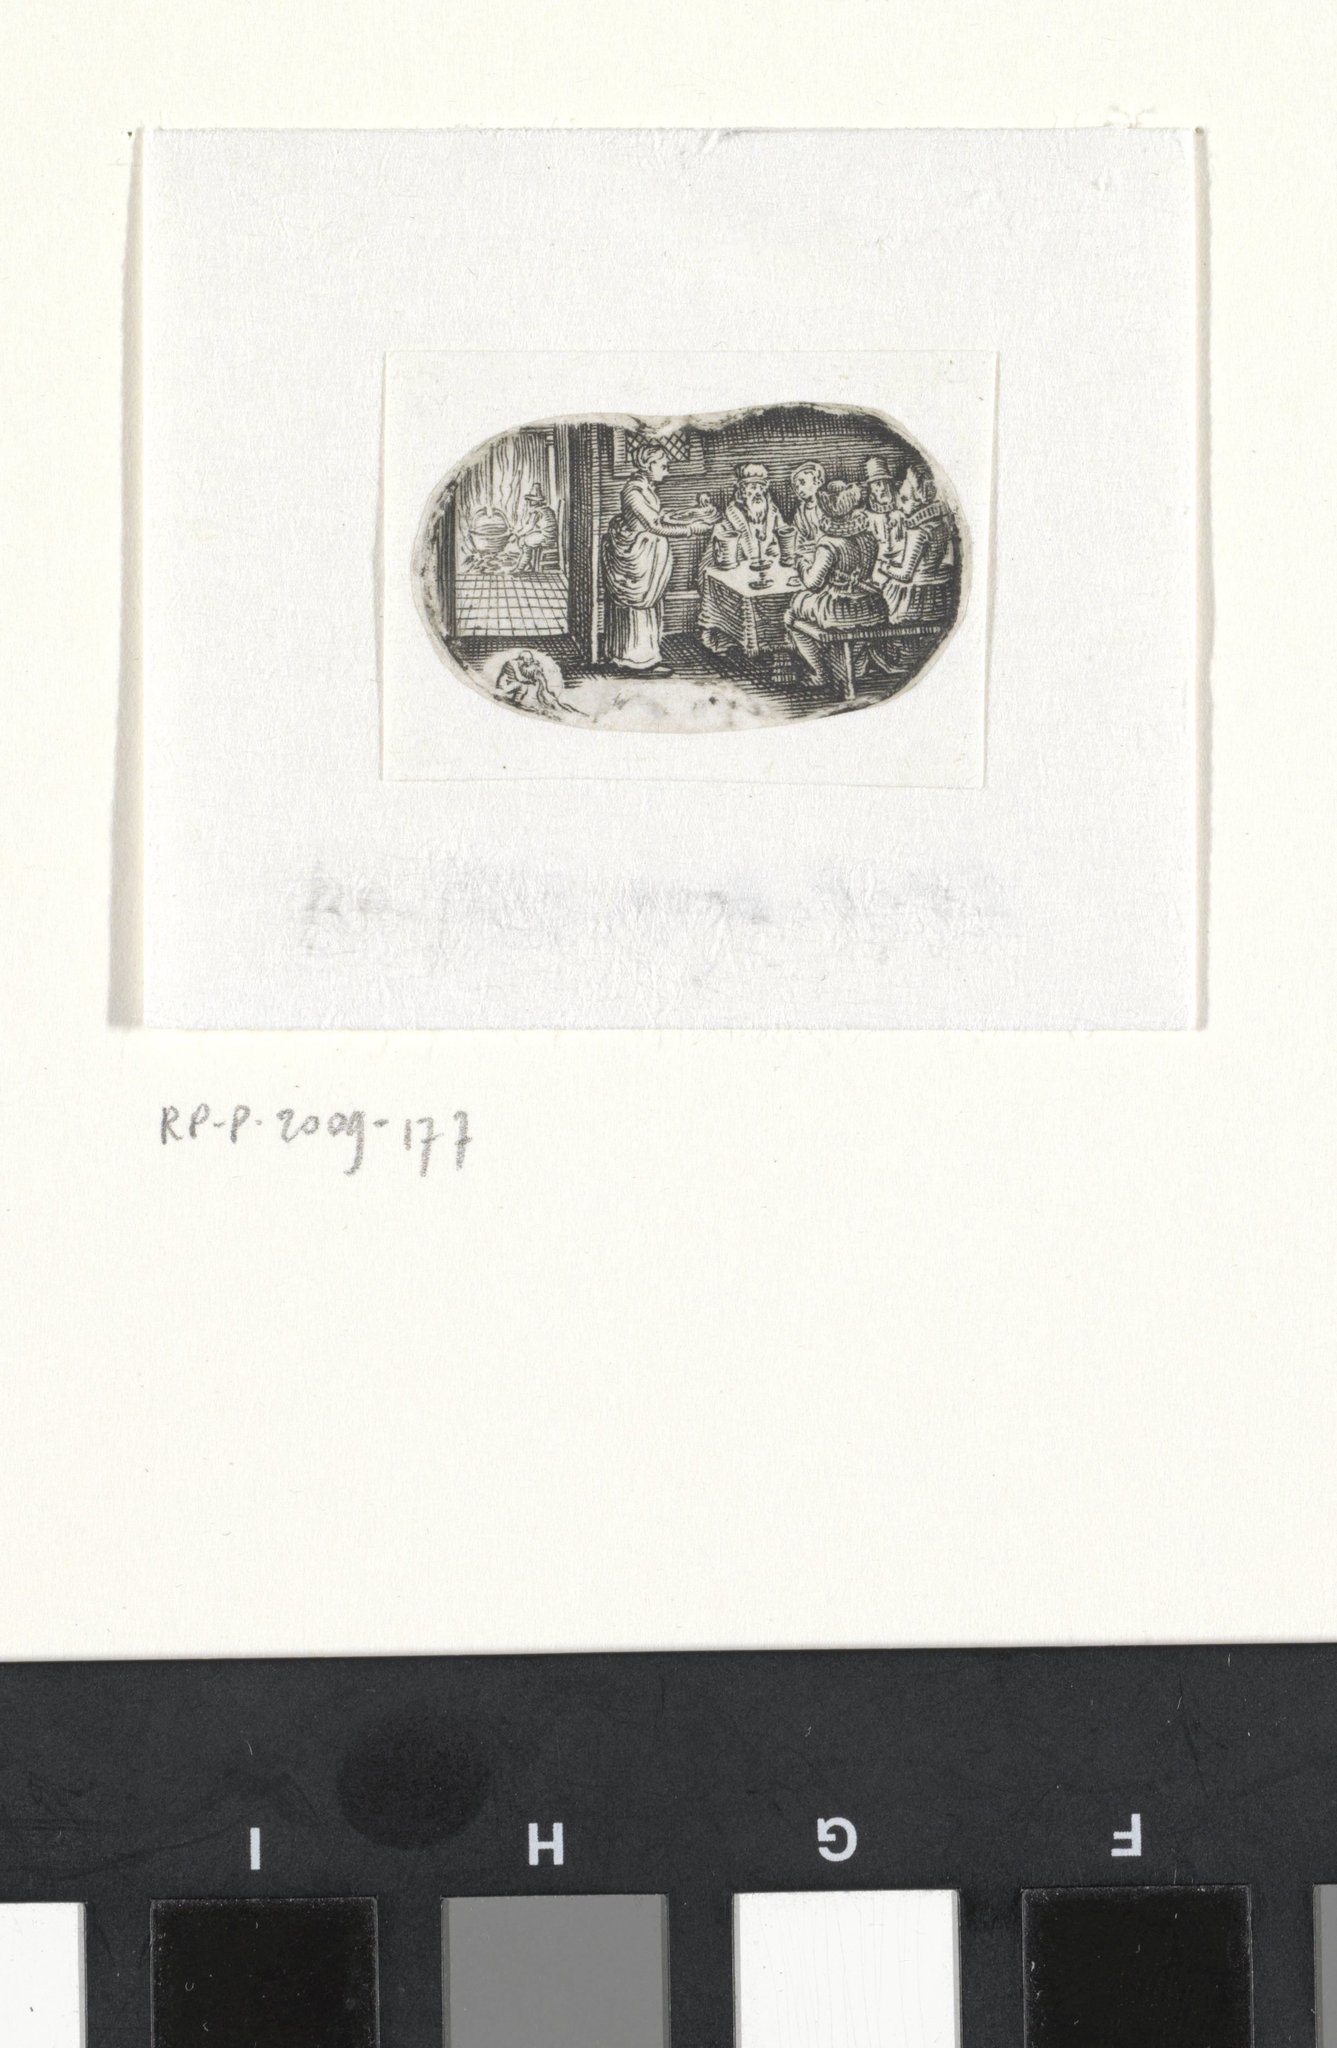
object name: print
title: Januari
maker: Anonymous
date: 1625-1700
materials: paper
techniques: engraving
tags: january and its 'labours', warming oneself at a fire (or hearth, stove, fire-pan, brazier), evening meal, dinner, supper, aquarius (zodiacal sign of january)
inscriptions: collector's mark: Lugt 2228, collector's mark: Lugt 2760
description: Menselijke bezigheden in de maand januari. Interieur met vijf figuren zittend aan tafel. Links daarvan een vrouw die eten opdient. Op de achtergrond een doorkijkje naar de keuken waar een man bij een boven het vuur hangende ketel zit. Linksonder het sterrenbeeld Waterman.